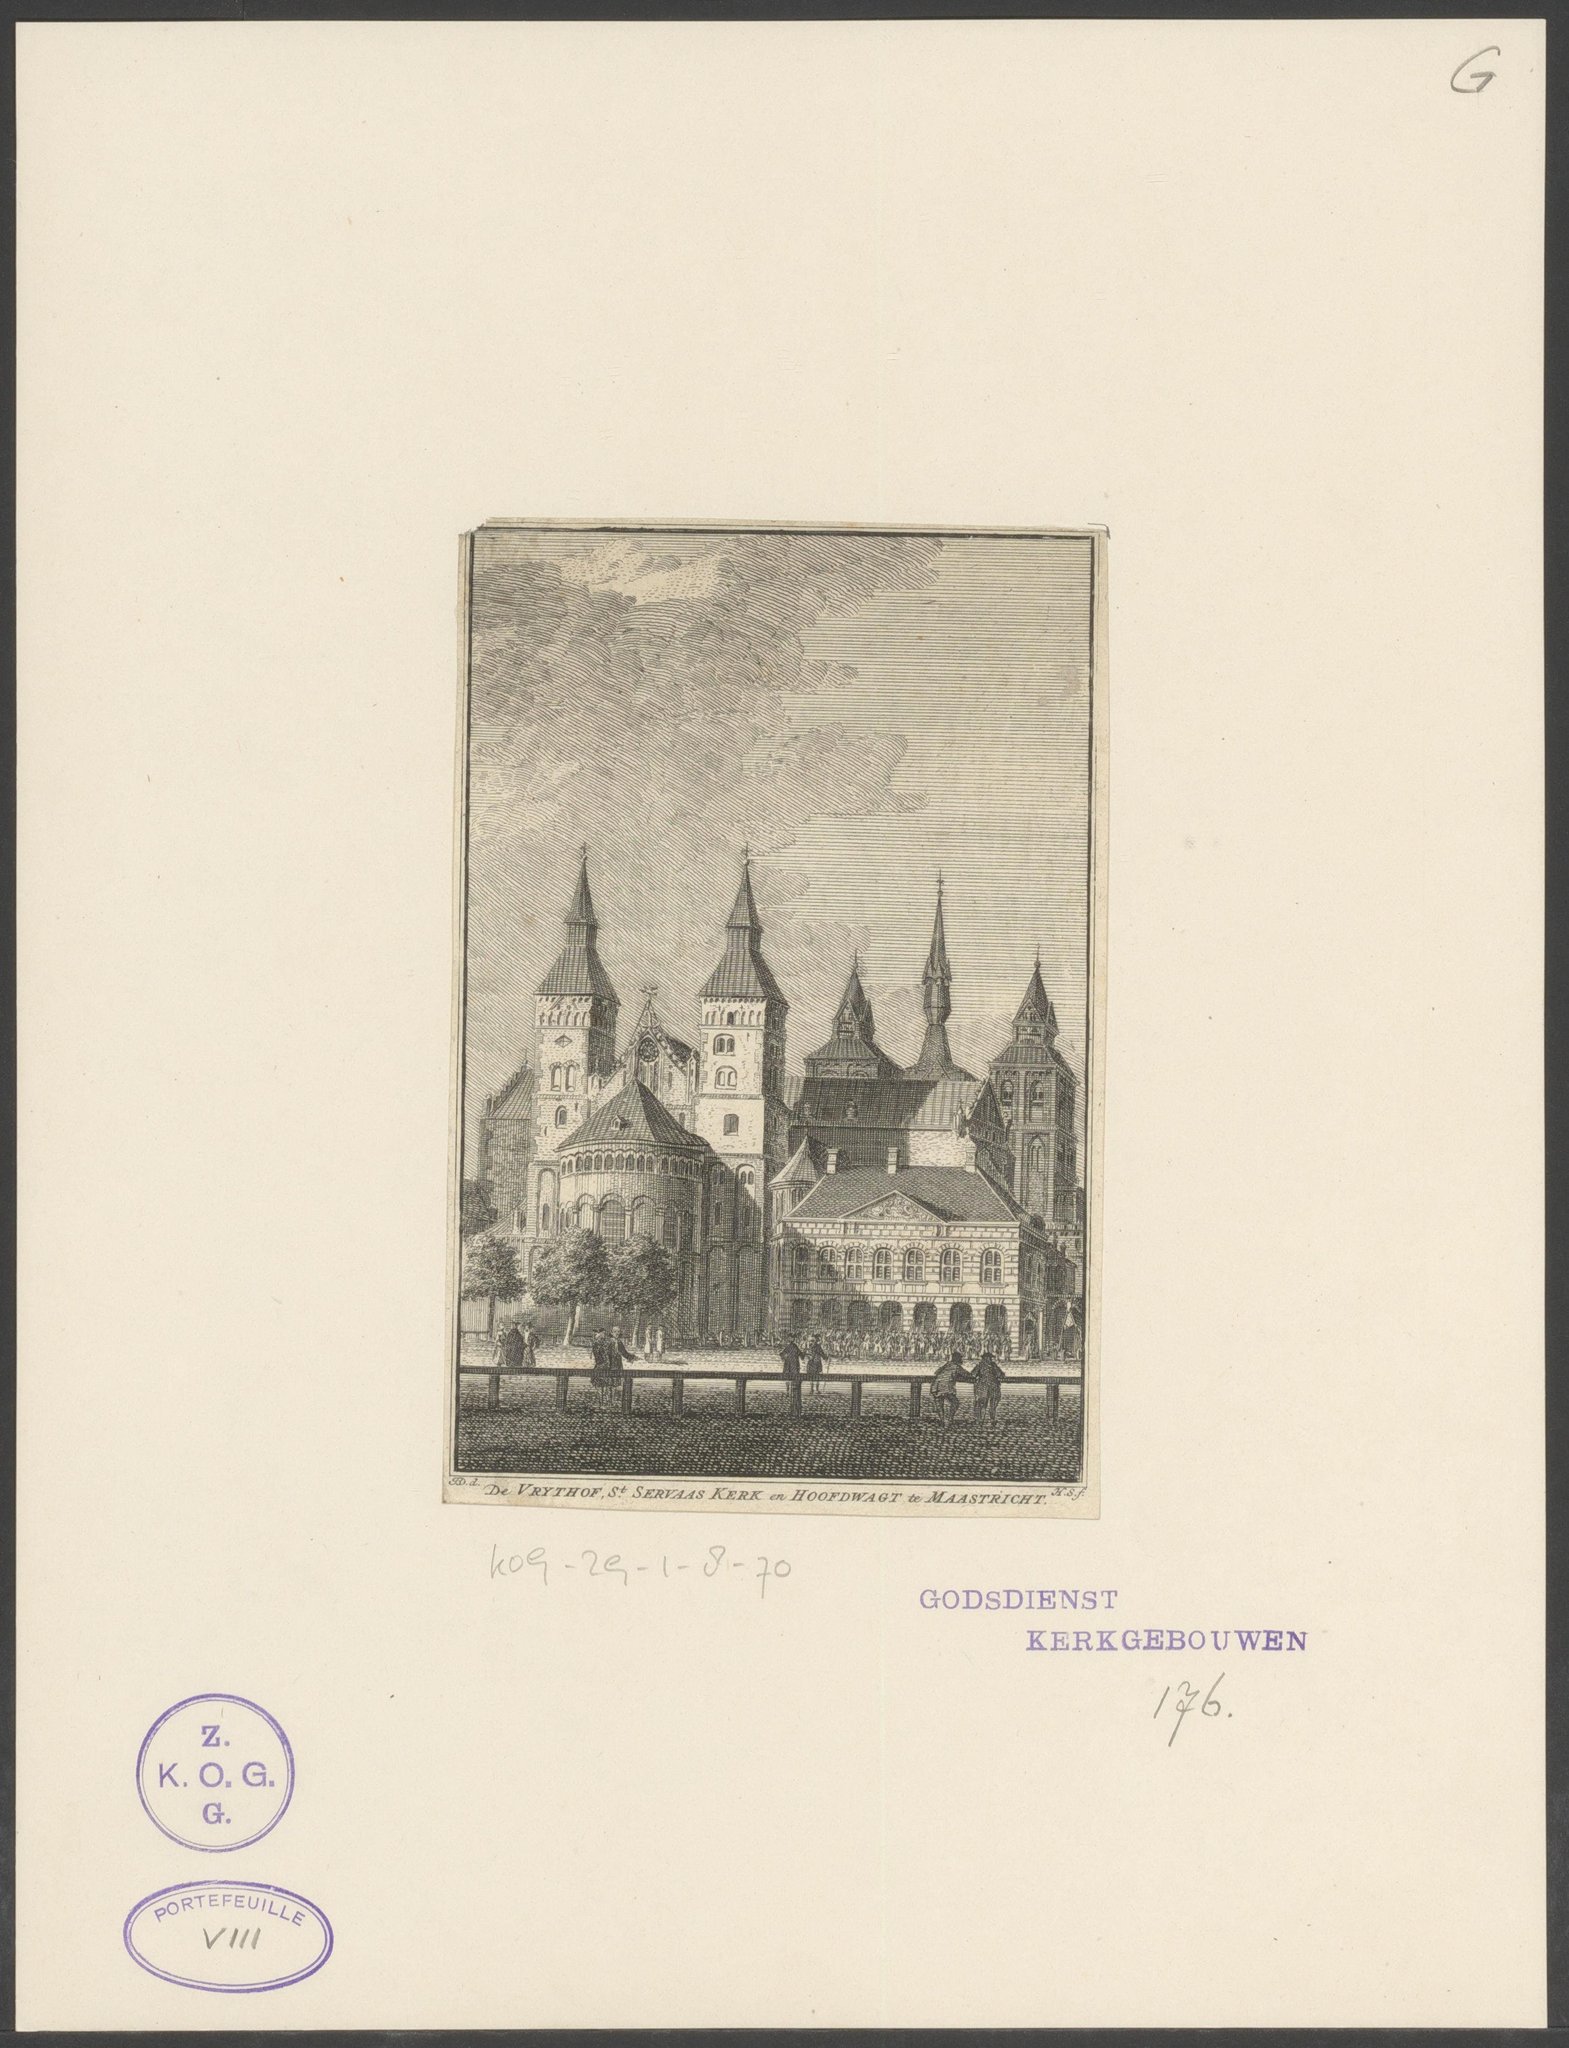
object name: print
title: Gezicht op het Vrijthof, de Sint-Servaasbasiliek en de Hoofdwacht te Maastricht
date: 1746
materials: paper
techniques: engraving, etching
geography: netherlands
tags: church (exterior), village square, place (+ city(-scape) with figures, staffage)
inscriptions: collector's mark, collector's mark: Lugt 1641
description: Prent eerst gebruikt in: Spilman, Hendrik. Het verheerlykt Nederland, of kabinet van hedendaagsche gezigten. 9 dln. Amsterdam: Isaac Tirion, 1745-1774, dl. 2 (1746), ill. 125-126. Later in: Nederlandsche tafereelen; of eene keurige verzameling van negen honderd fraaije gezigten van steden, dorpen, sloten, oudheden (...). 9 delen. Amsterdam: Jan de Groot, 1792, dl. 2, ill. 125-126.